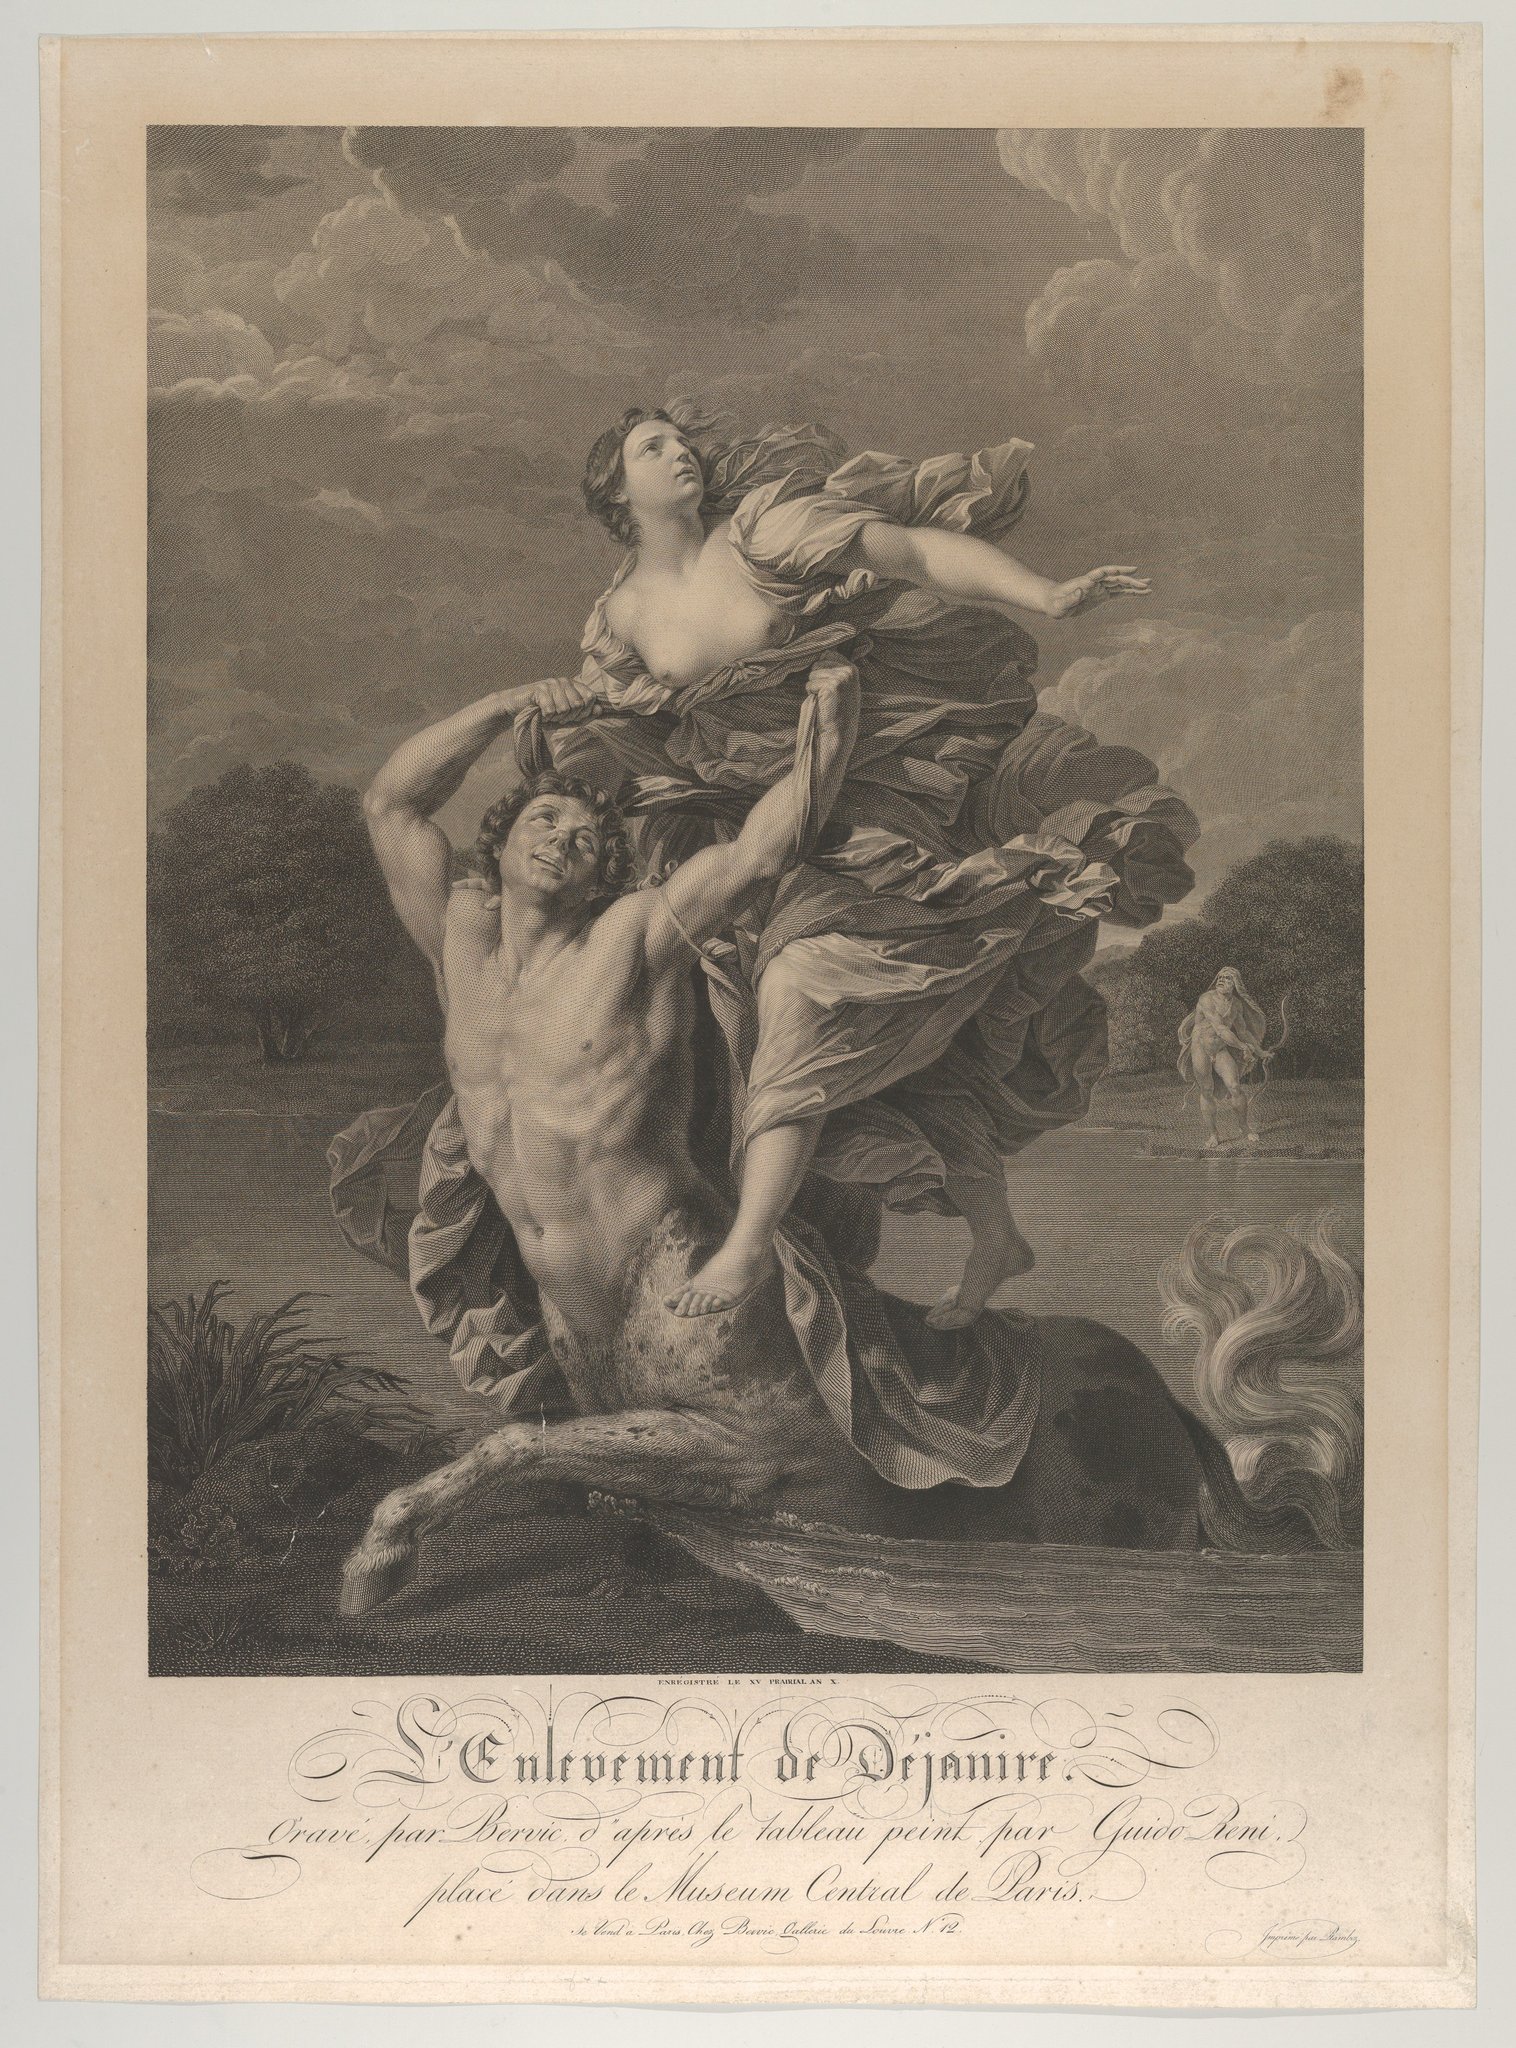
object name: print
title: Dejanira being abducted by the centaur Nessos, a man with bow and arrow at right, after Reni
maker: charles clément bervic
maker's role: artist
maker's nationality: french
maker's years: 1756-1822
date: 1802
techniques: engraving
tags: women,centaurs